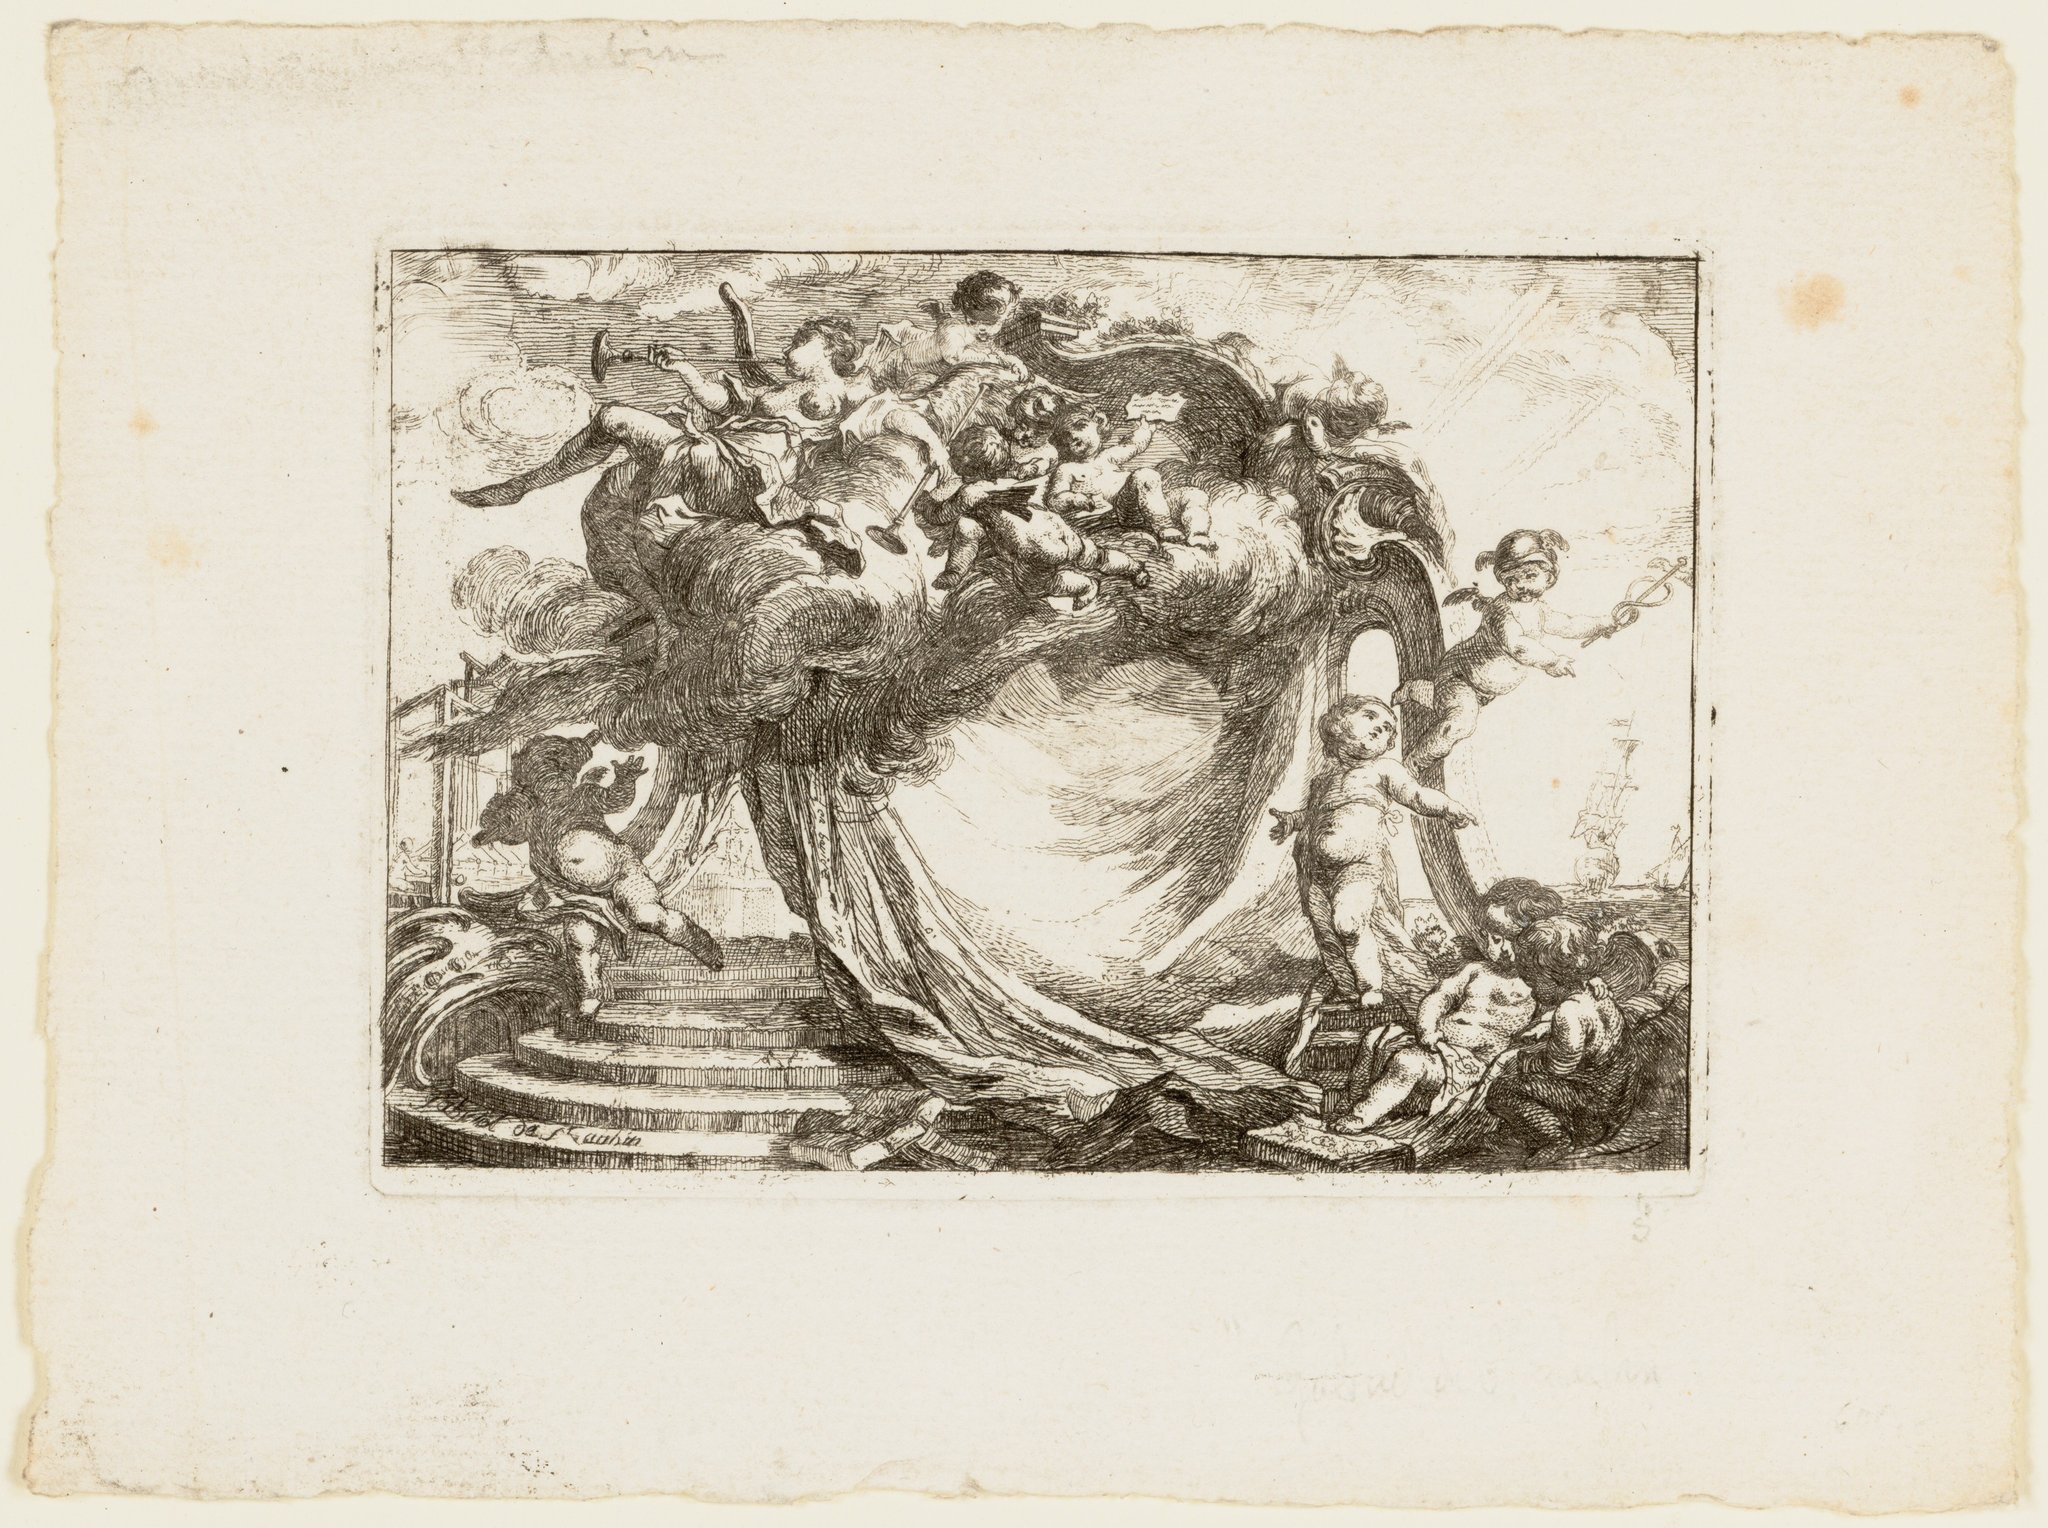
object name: print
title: Trade Card for a Textile Merchant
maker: gabriel de saint-aubin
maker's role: artist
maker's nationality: french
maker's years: 1724-1780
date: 1752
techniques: etching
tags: trumpets